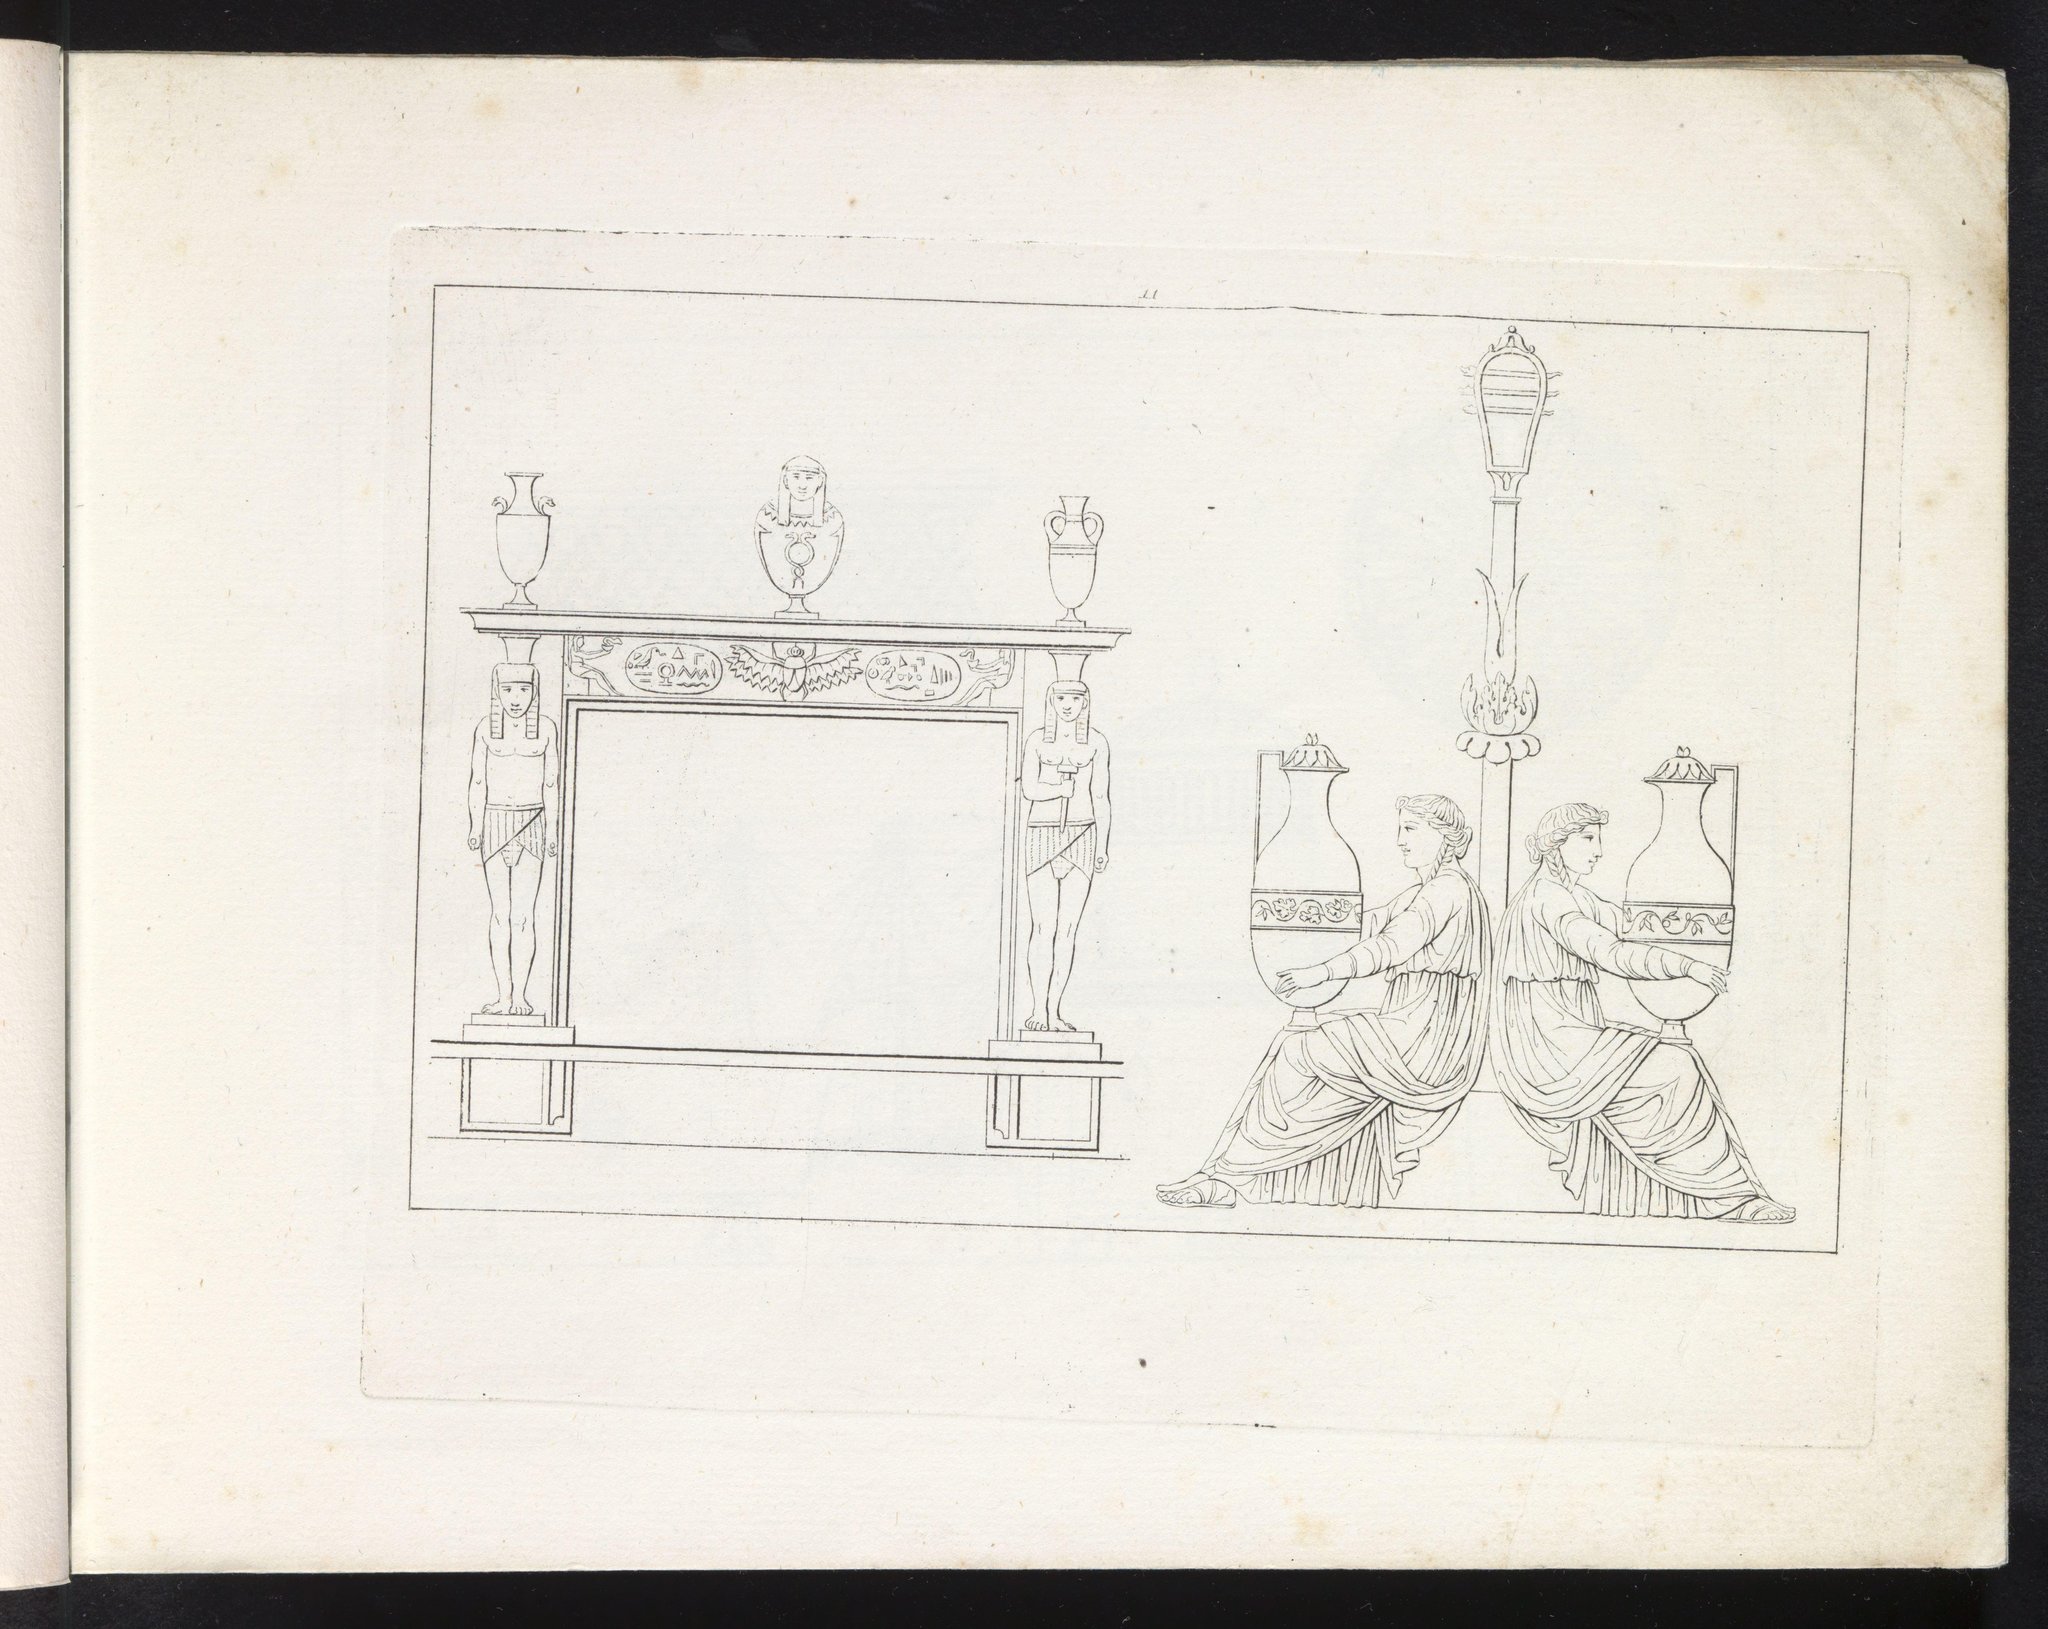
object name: album leaf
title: Ontwerpen voor religieuze en profane voorwerpen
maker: pietro ruga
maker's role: print maker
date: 1817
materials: paper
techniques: etching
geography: milan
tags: ornaments ~ art, chandelier, candelabrum, open hearth, fire-place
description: Prent maakt deel uit van een reeks van 100 prenten (+ titelprent) met ontwerpen voor religieuze en profane voorwerpen.